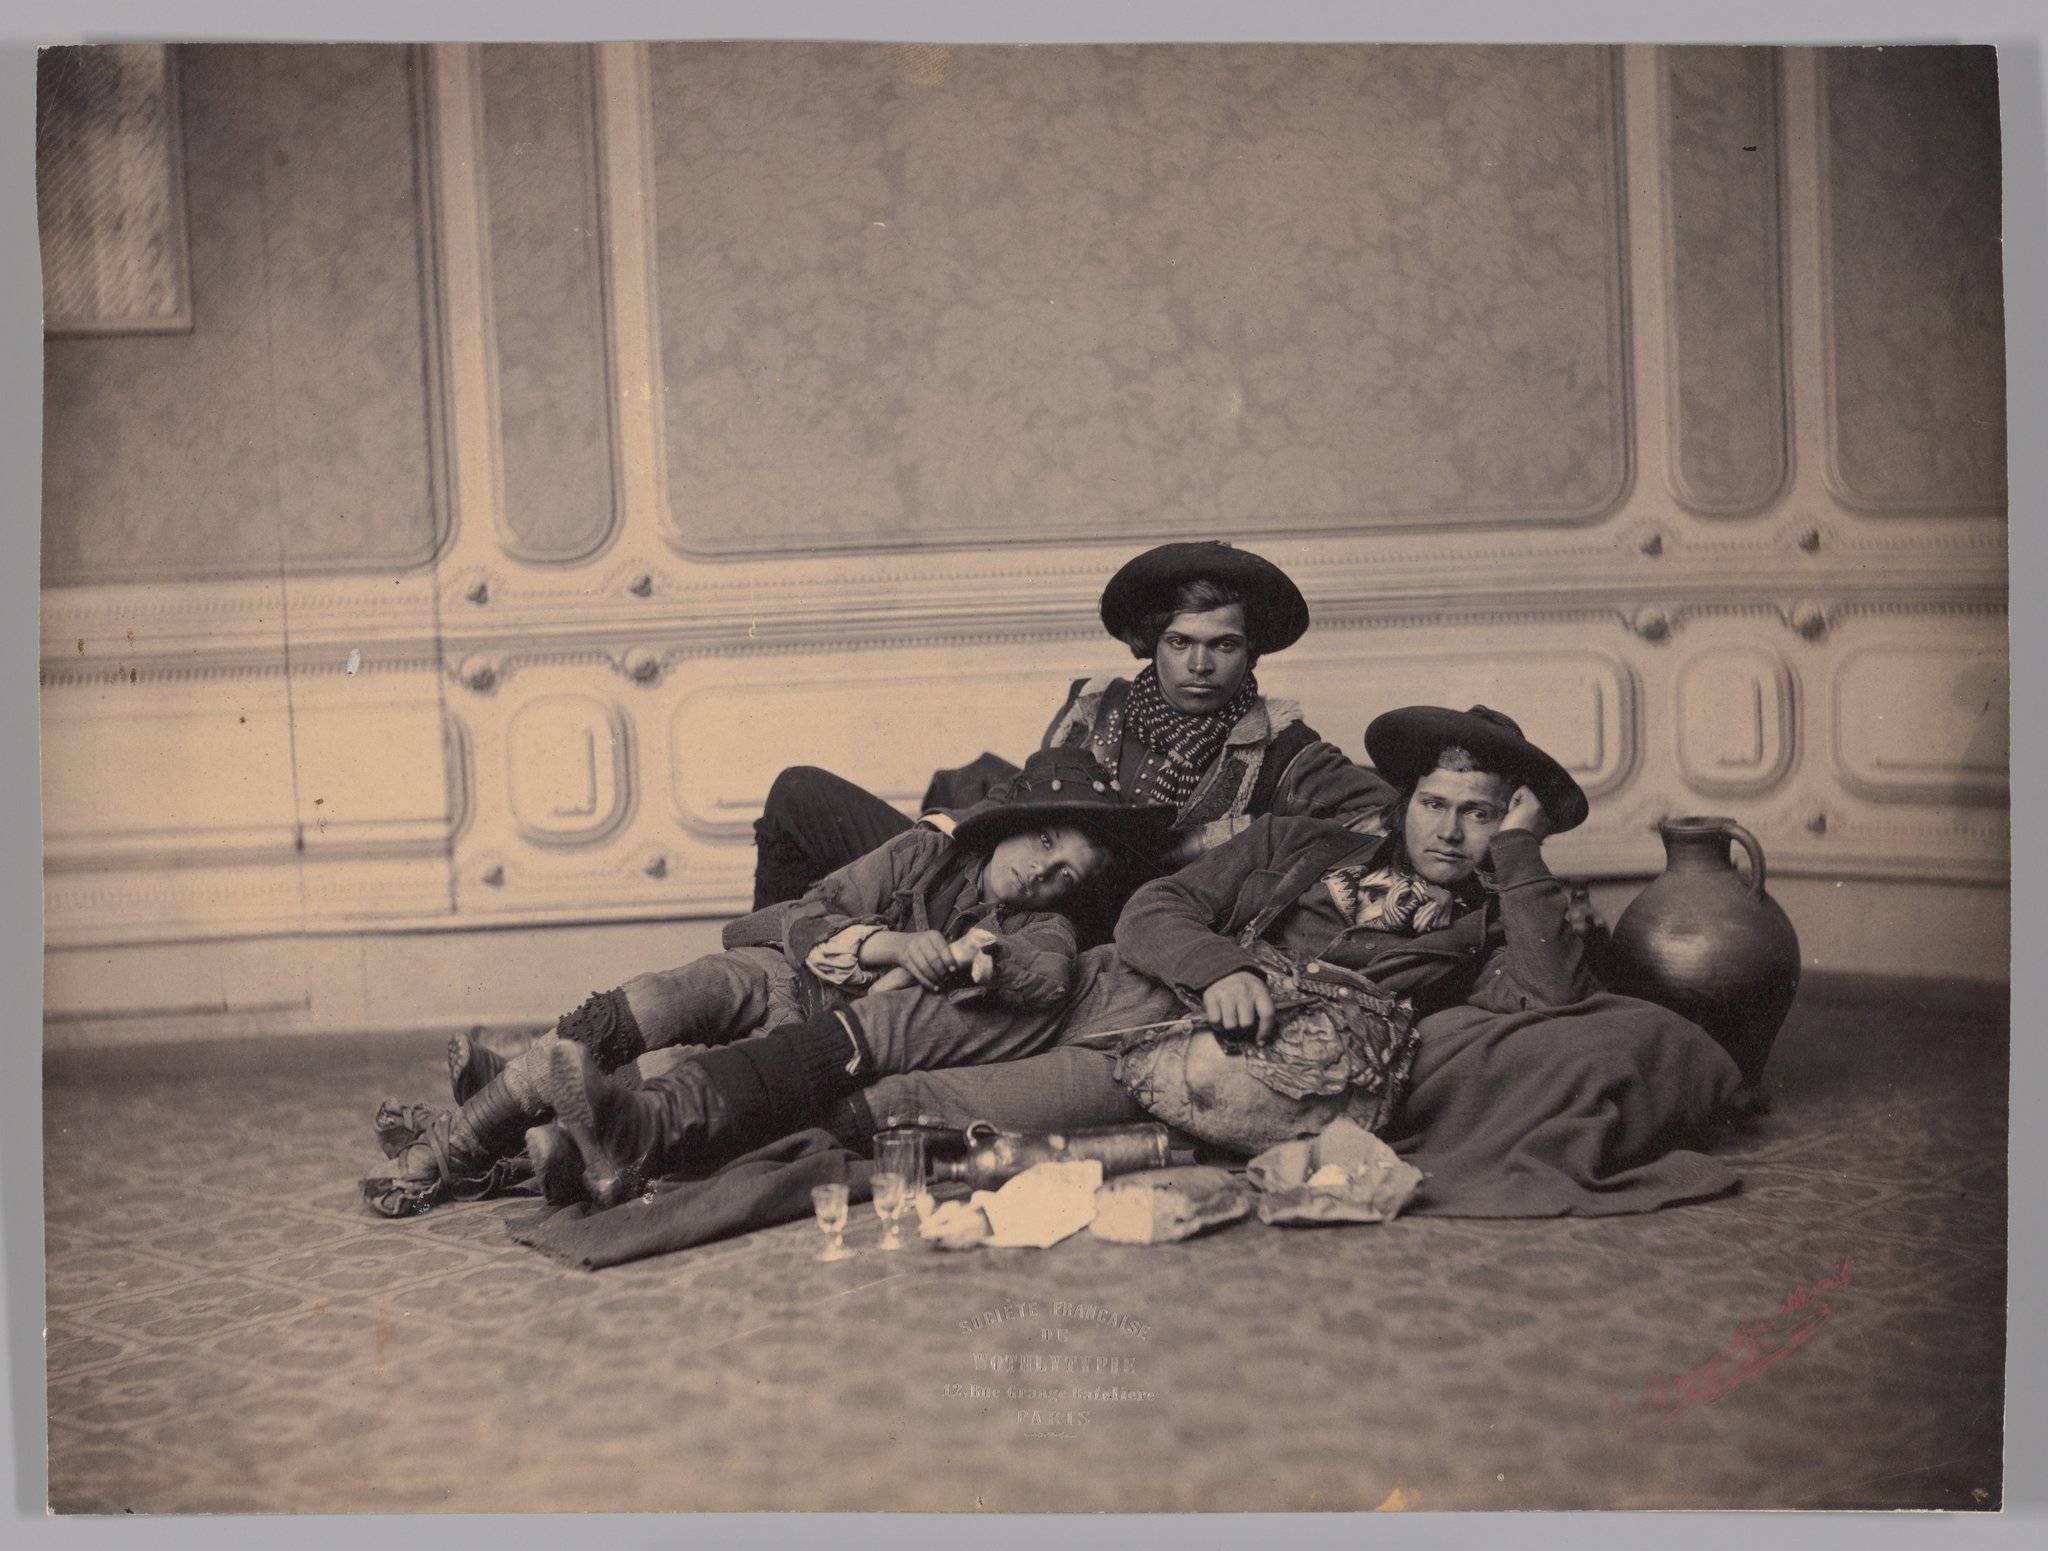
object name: photograph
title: Hirten / Pifferari mit Brotzeit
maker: jacob wothly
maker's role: artist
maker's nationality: german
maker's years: 1823-1873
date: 1864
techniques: glass negative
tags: boys,men,portraits